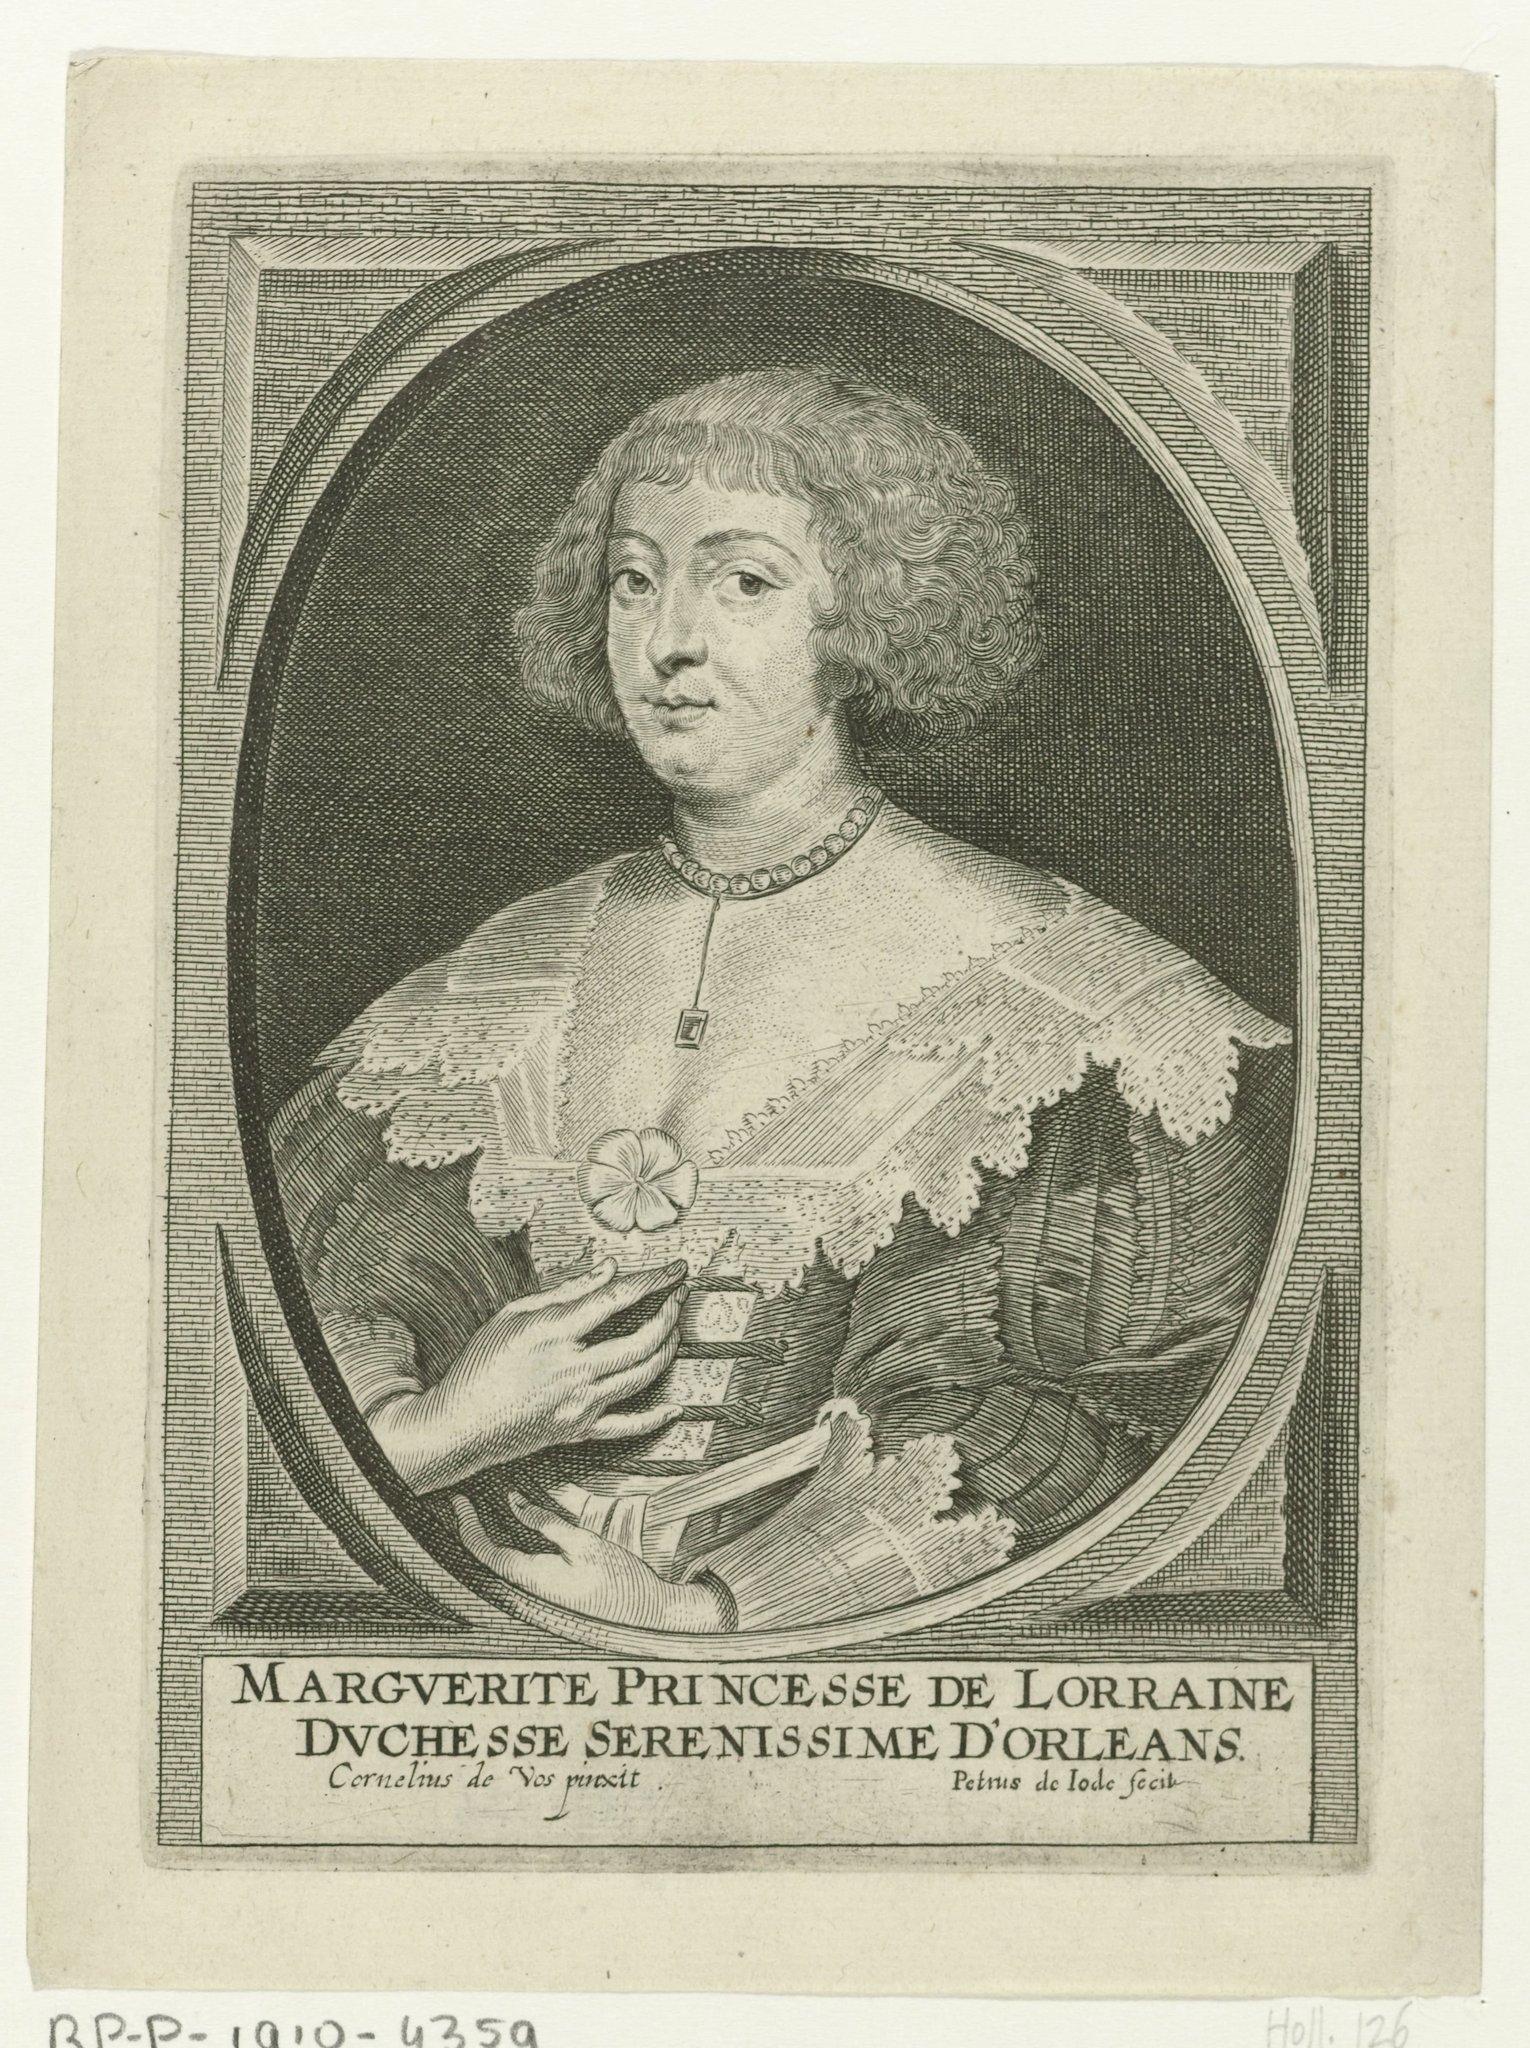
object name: print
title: Theater van bisschoppen, keizers, koningen, hertogen, prinsen, enz.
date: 1628-1670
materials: paper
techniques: engraving, etching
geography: antwerp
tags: argentan, margaretha van lotharingen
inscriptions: collector's mark: Lugt 2228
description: Busteportret van Margaretha van Lotharingen,. Het portret is gevat in een ovale omlijsting met vierkant randwerk. In het kader een tweeregelig onderschrift in het Latijn.